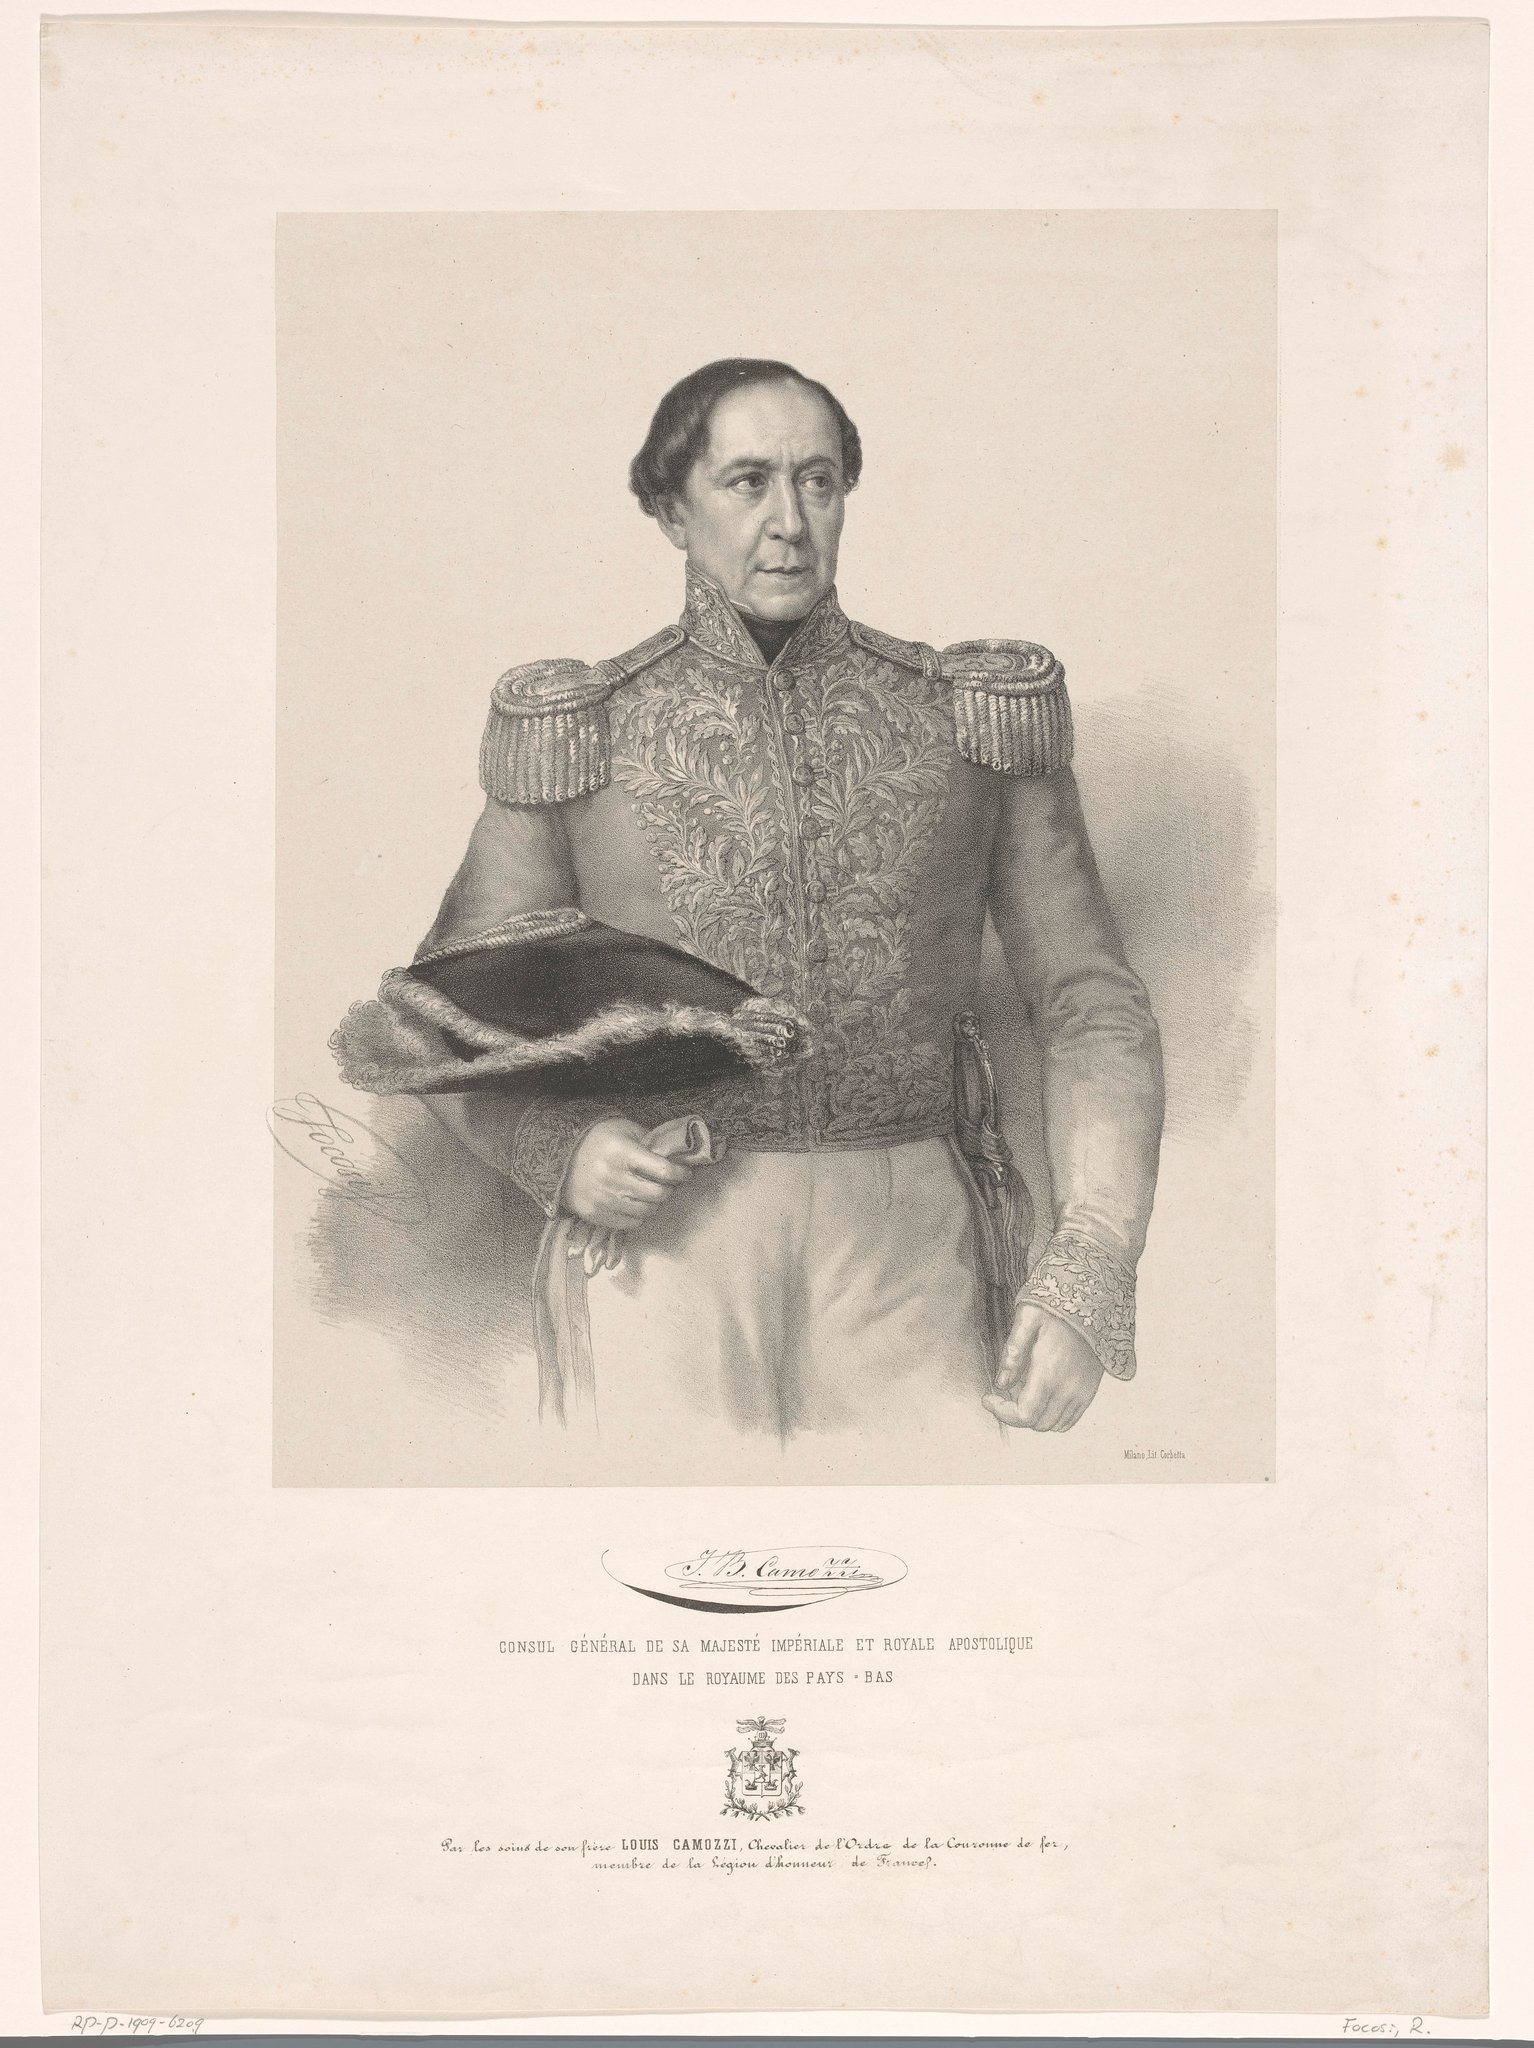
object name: print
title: Portret van generaal J.B. Camozzi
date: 1816-1862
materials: paper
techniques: lithograph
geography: italy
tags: commander-in-chief, general, marshal, historical persons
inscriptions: collector's mark: Lugt 2228